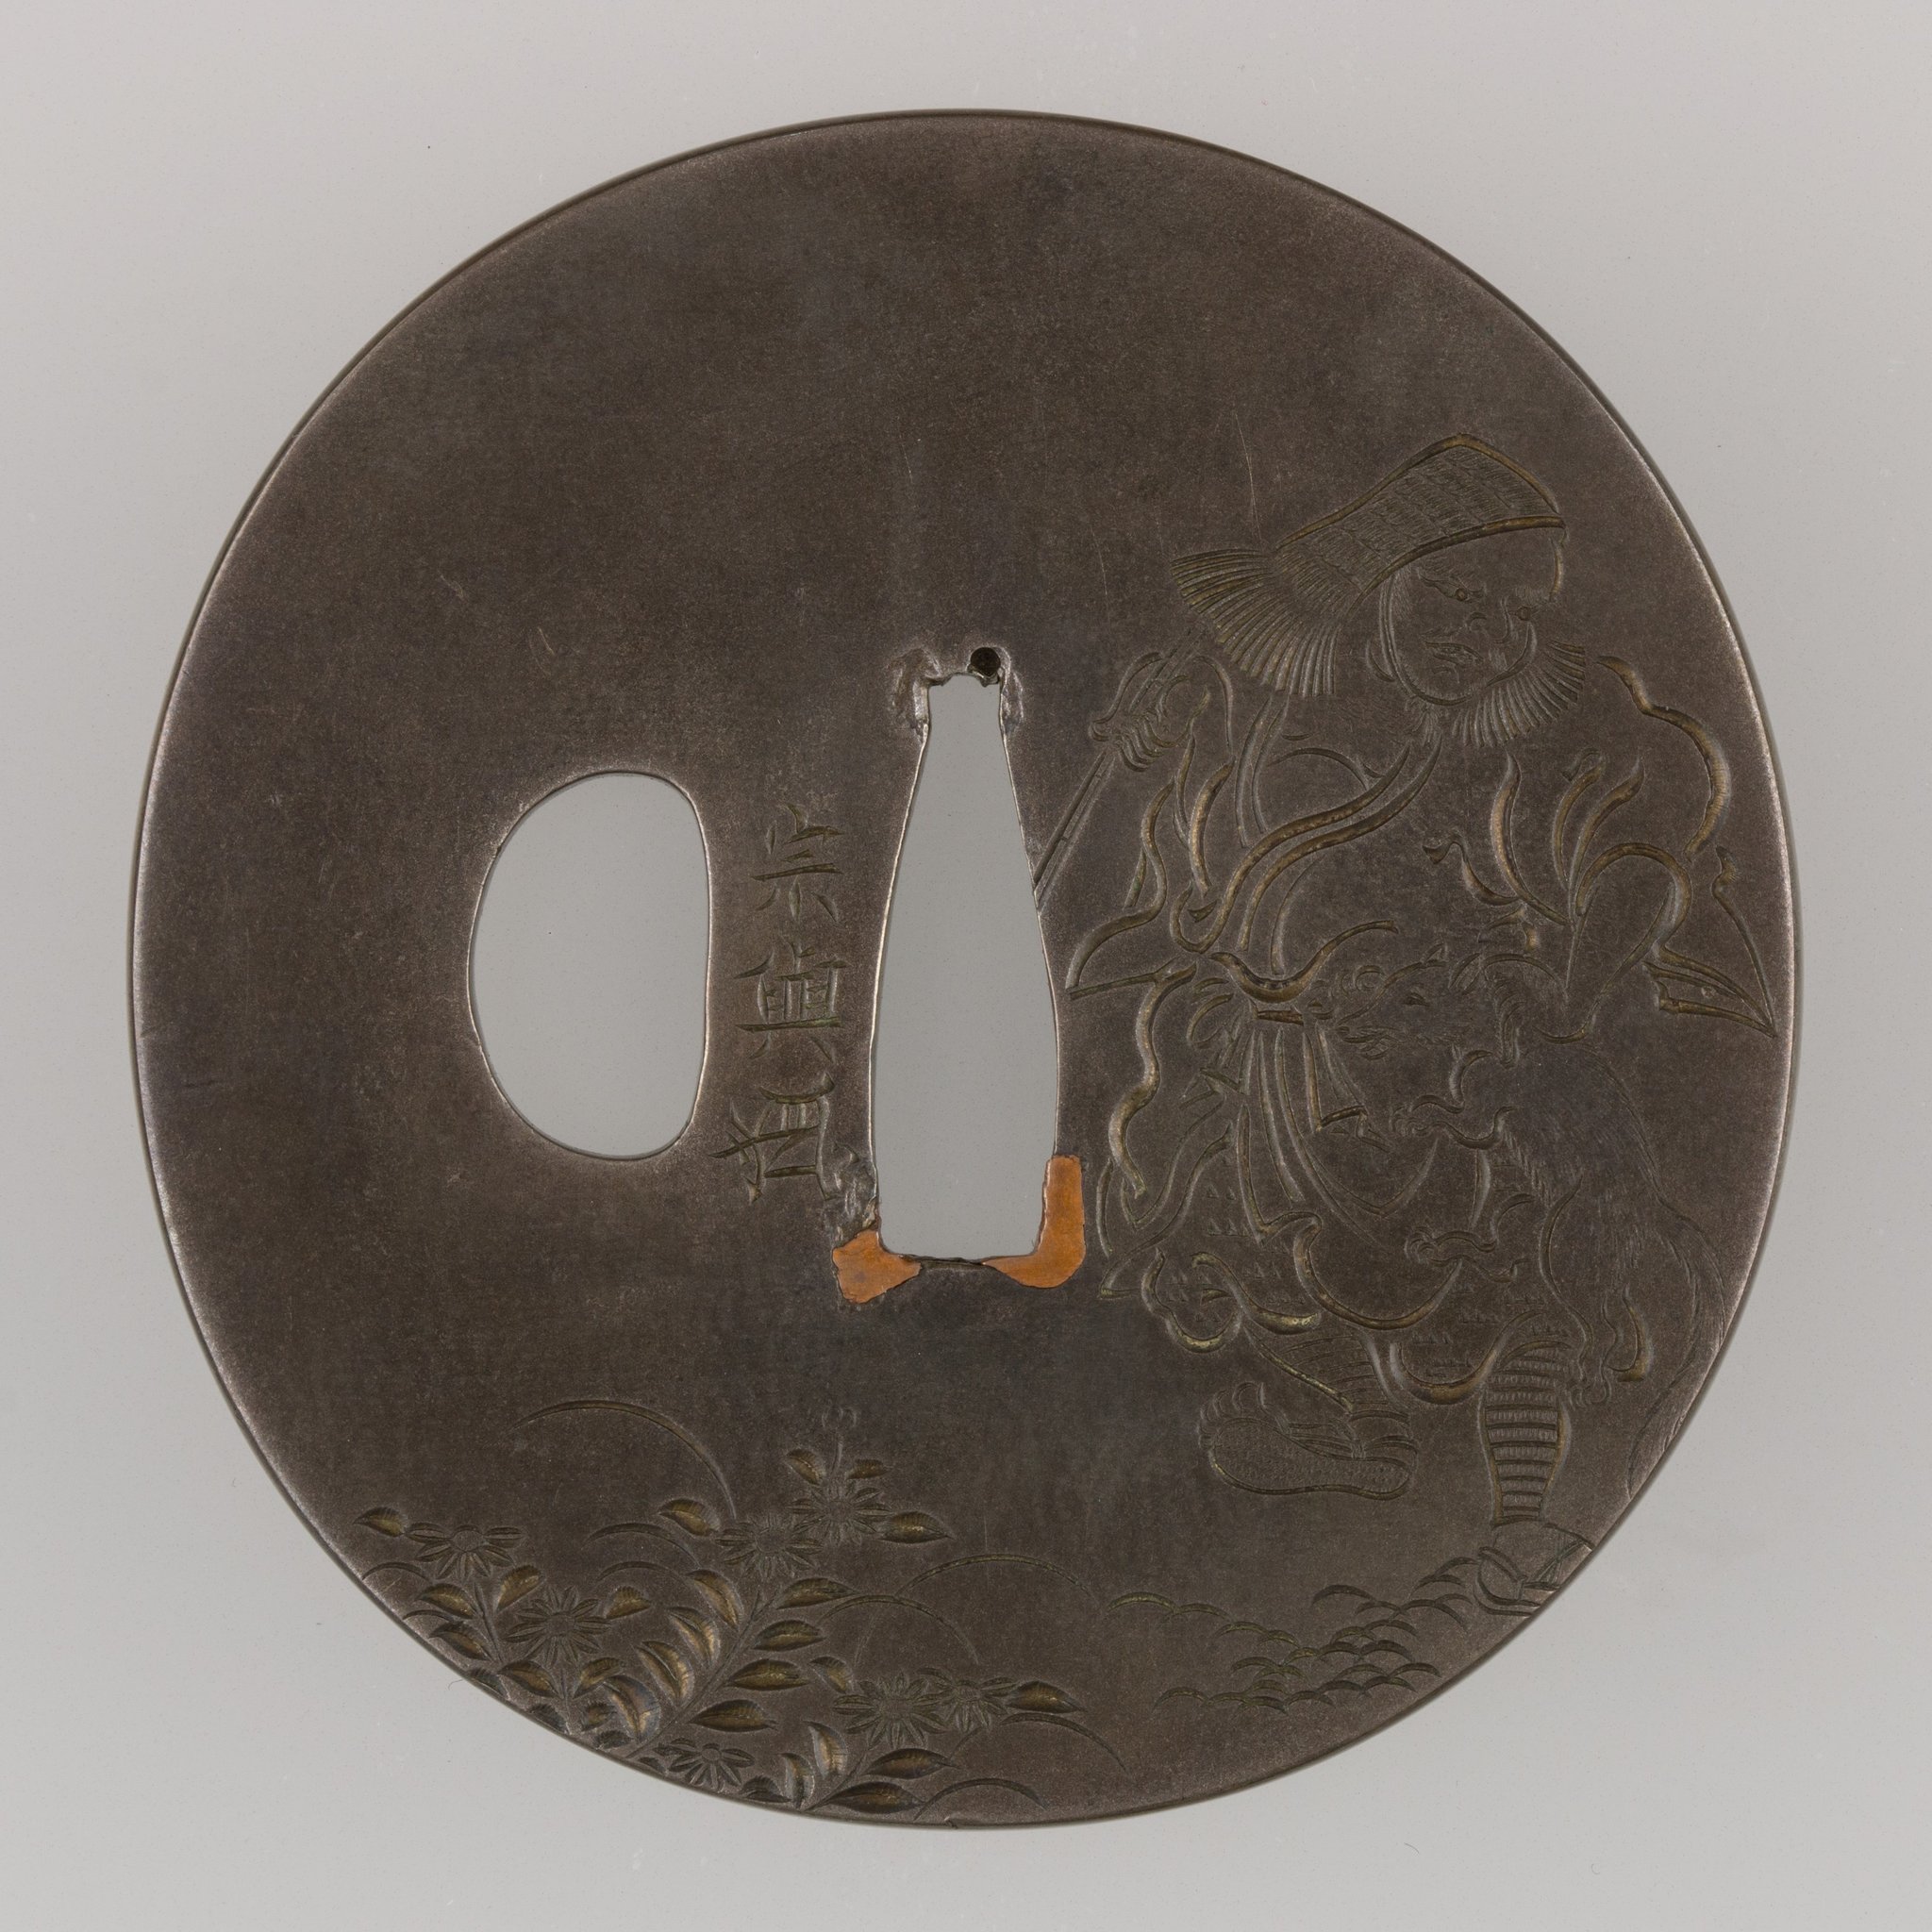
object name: sword guard tsuba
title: Sword Guard (Tsuba)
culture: japanese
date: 1701-1800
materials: copper, silver alloy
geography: japan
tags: men